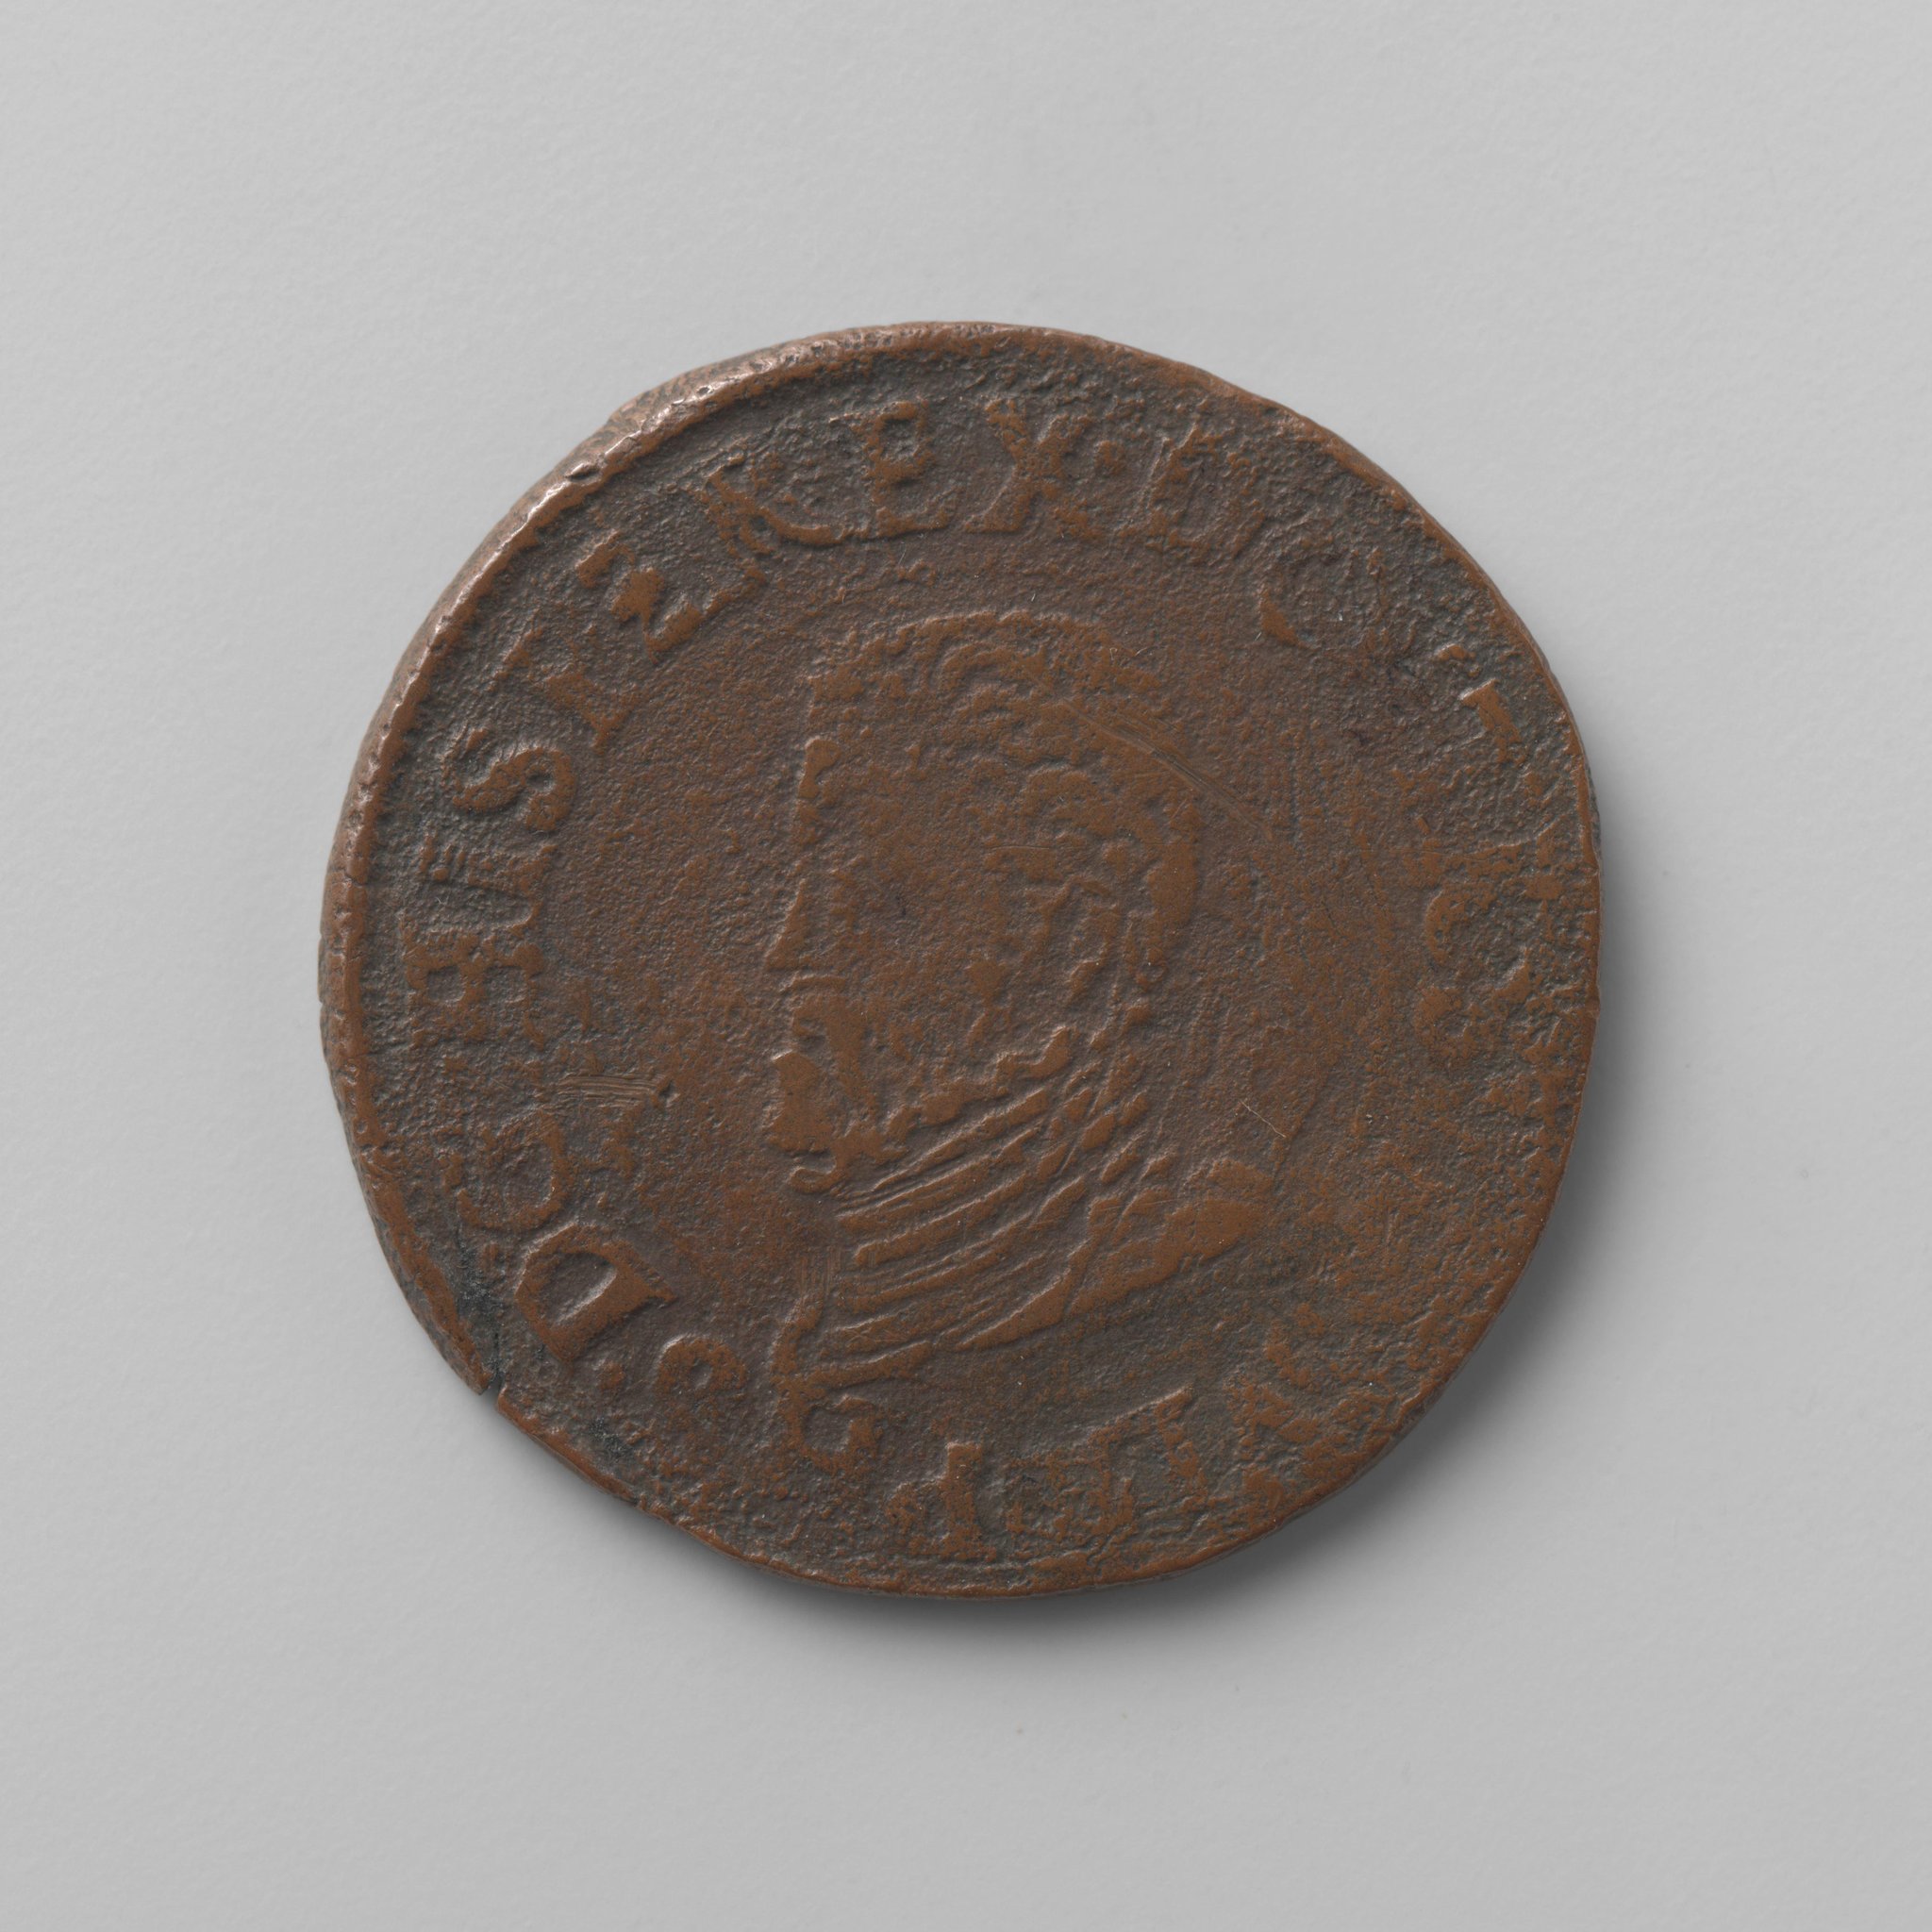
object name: coin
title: Overijssel, statenoord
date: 1577-1578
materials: copper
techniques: striking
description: Koperen munt. Voorzijde: borstbeeld van Philips II naar links. Keerzijde: door keten van het Gulden Vlies omhangen gekroond Bourgondisch wapenschild.